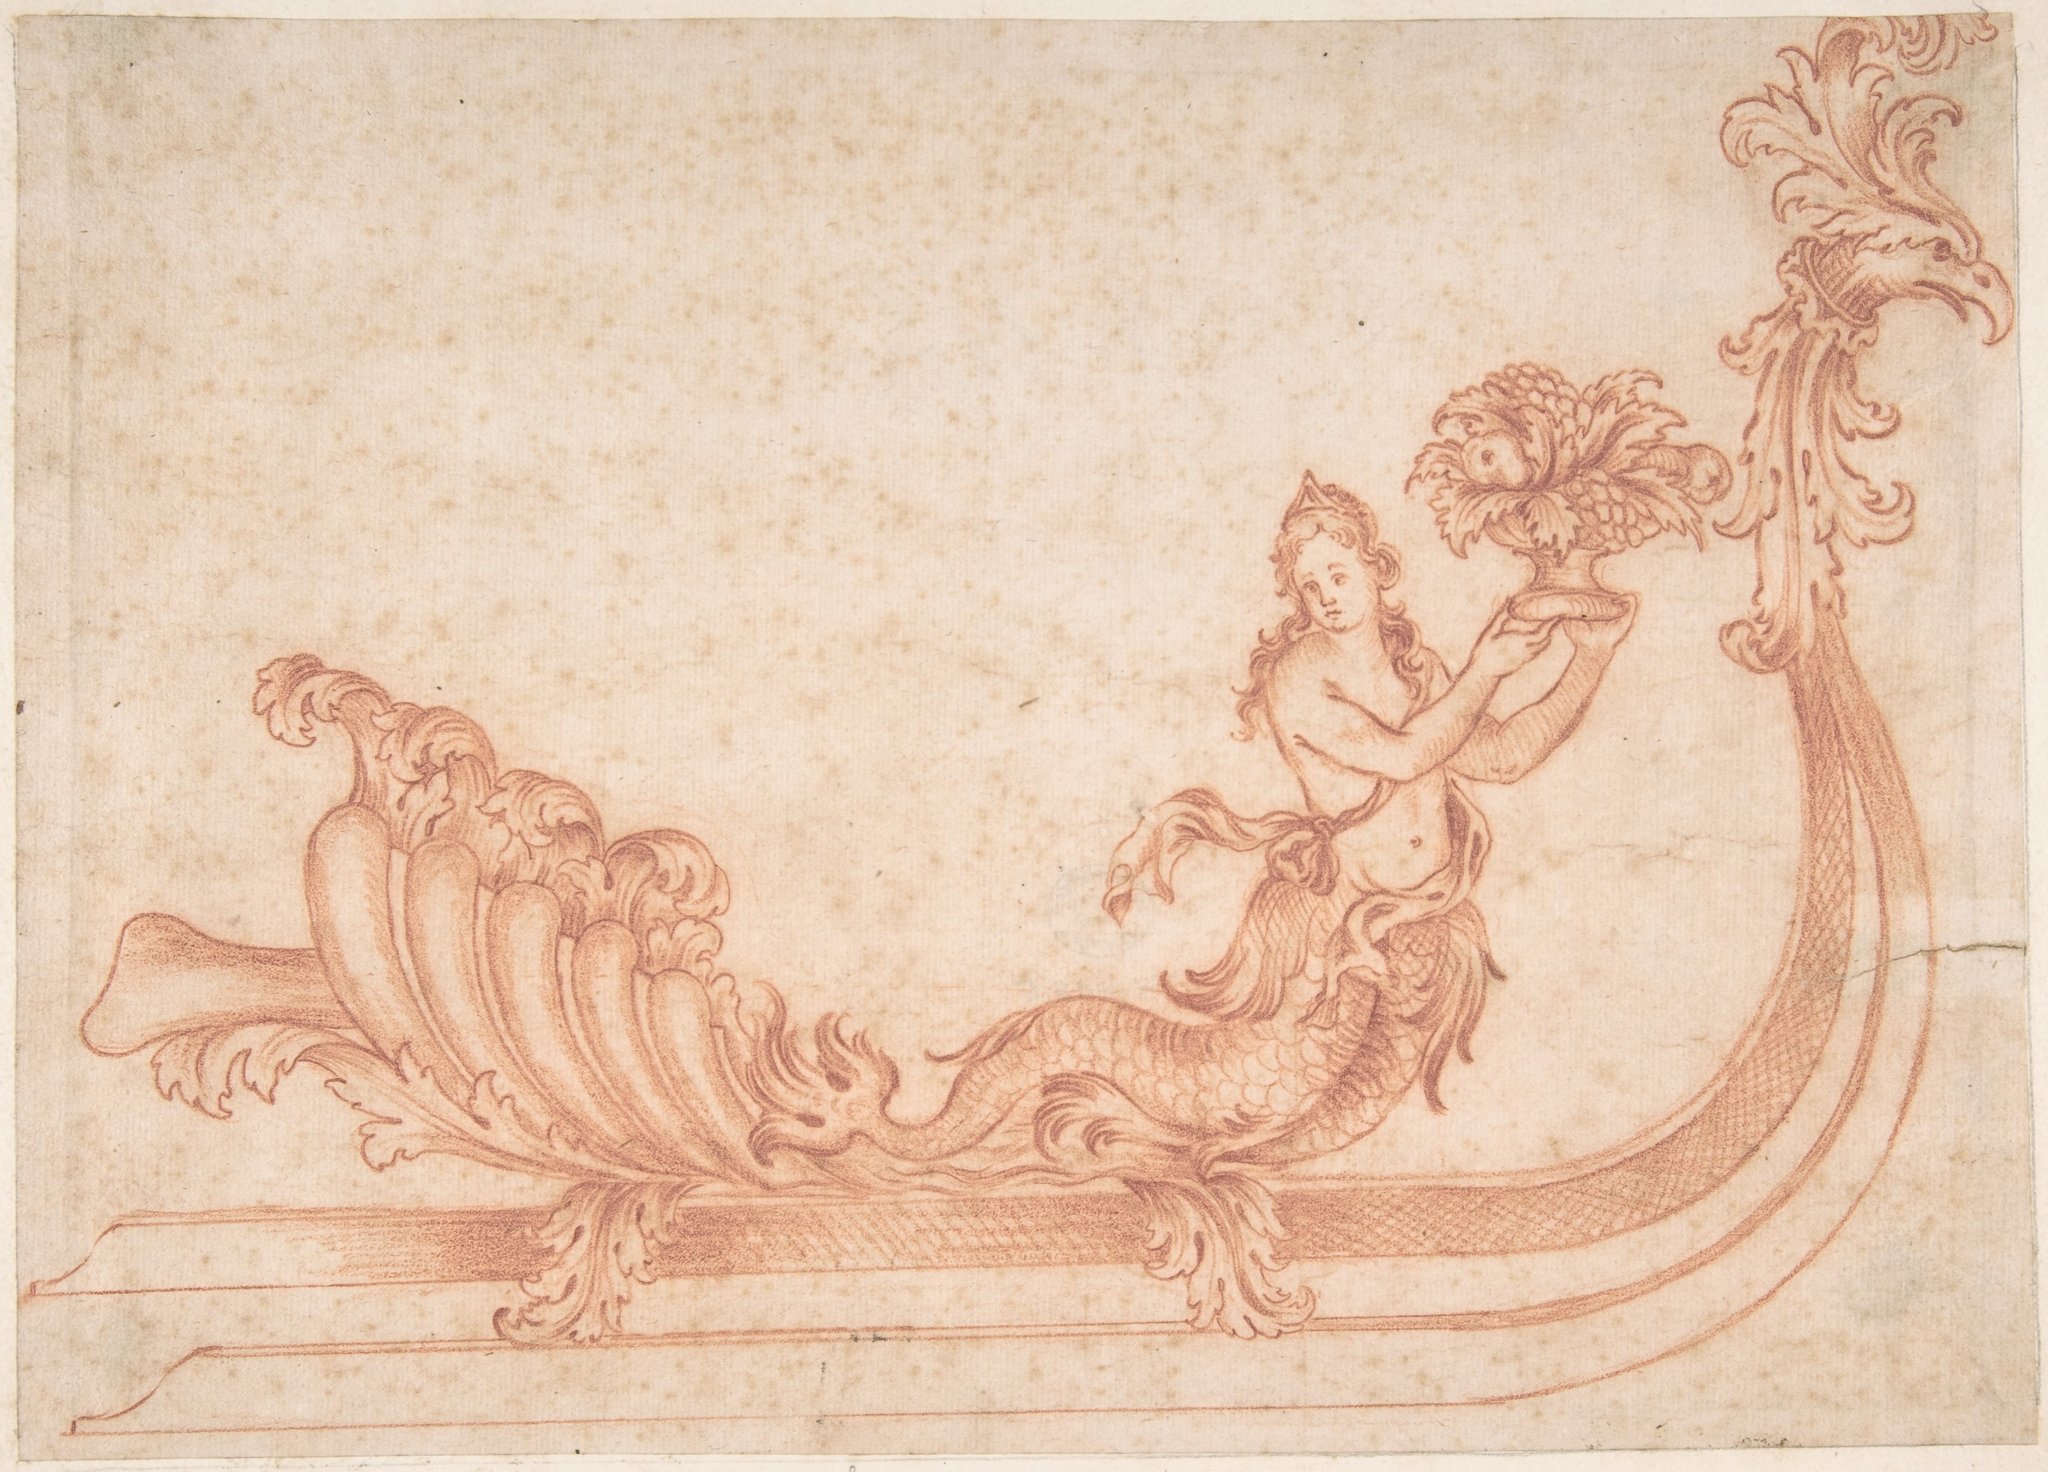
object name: drawing ornament architecture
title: Design for a Sleigh with a Mermaid Holding a Vessel with Fruit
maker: anonymous, german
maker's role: artist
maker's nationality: german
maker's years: 1400-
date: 1701-1800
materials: chalk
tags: fruit,mermaids